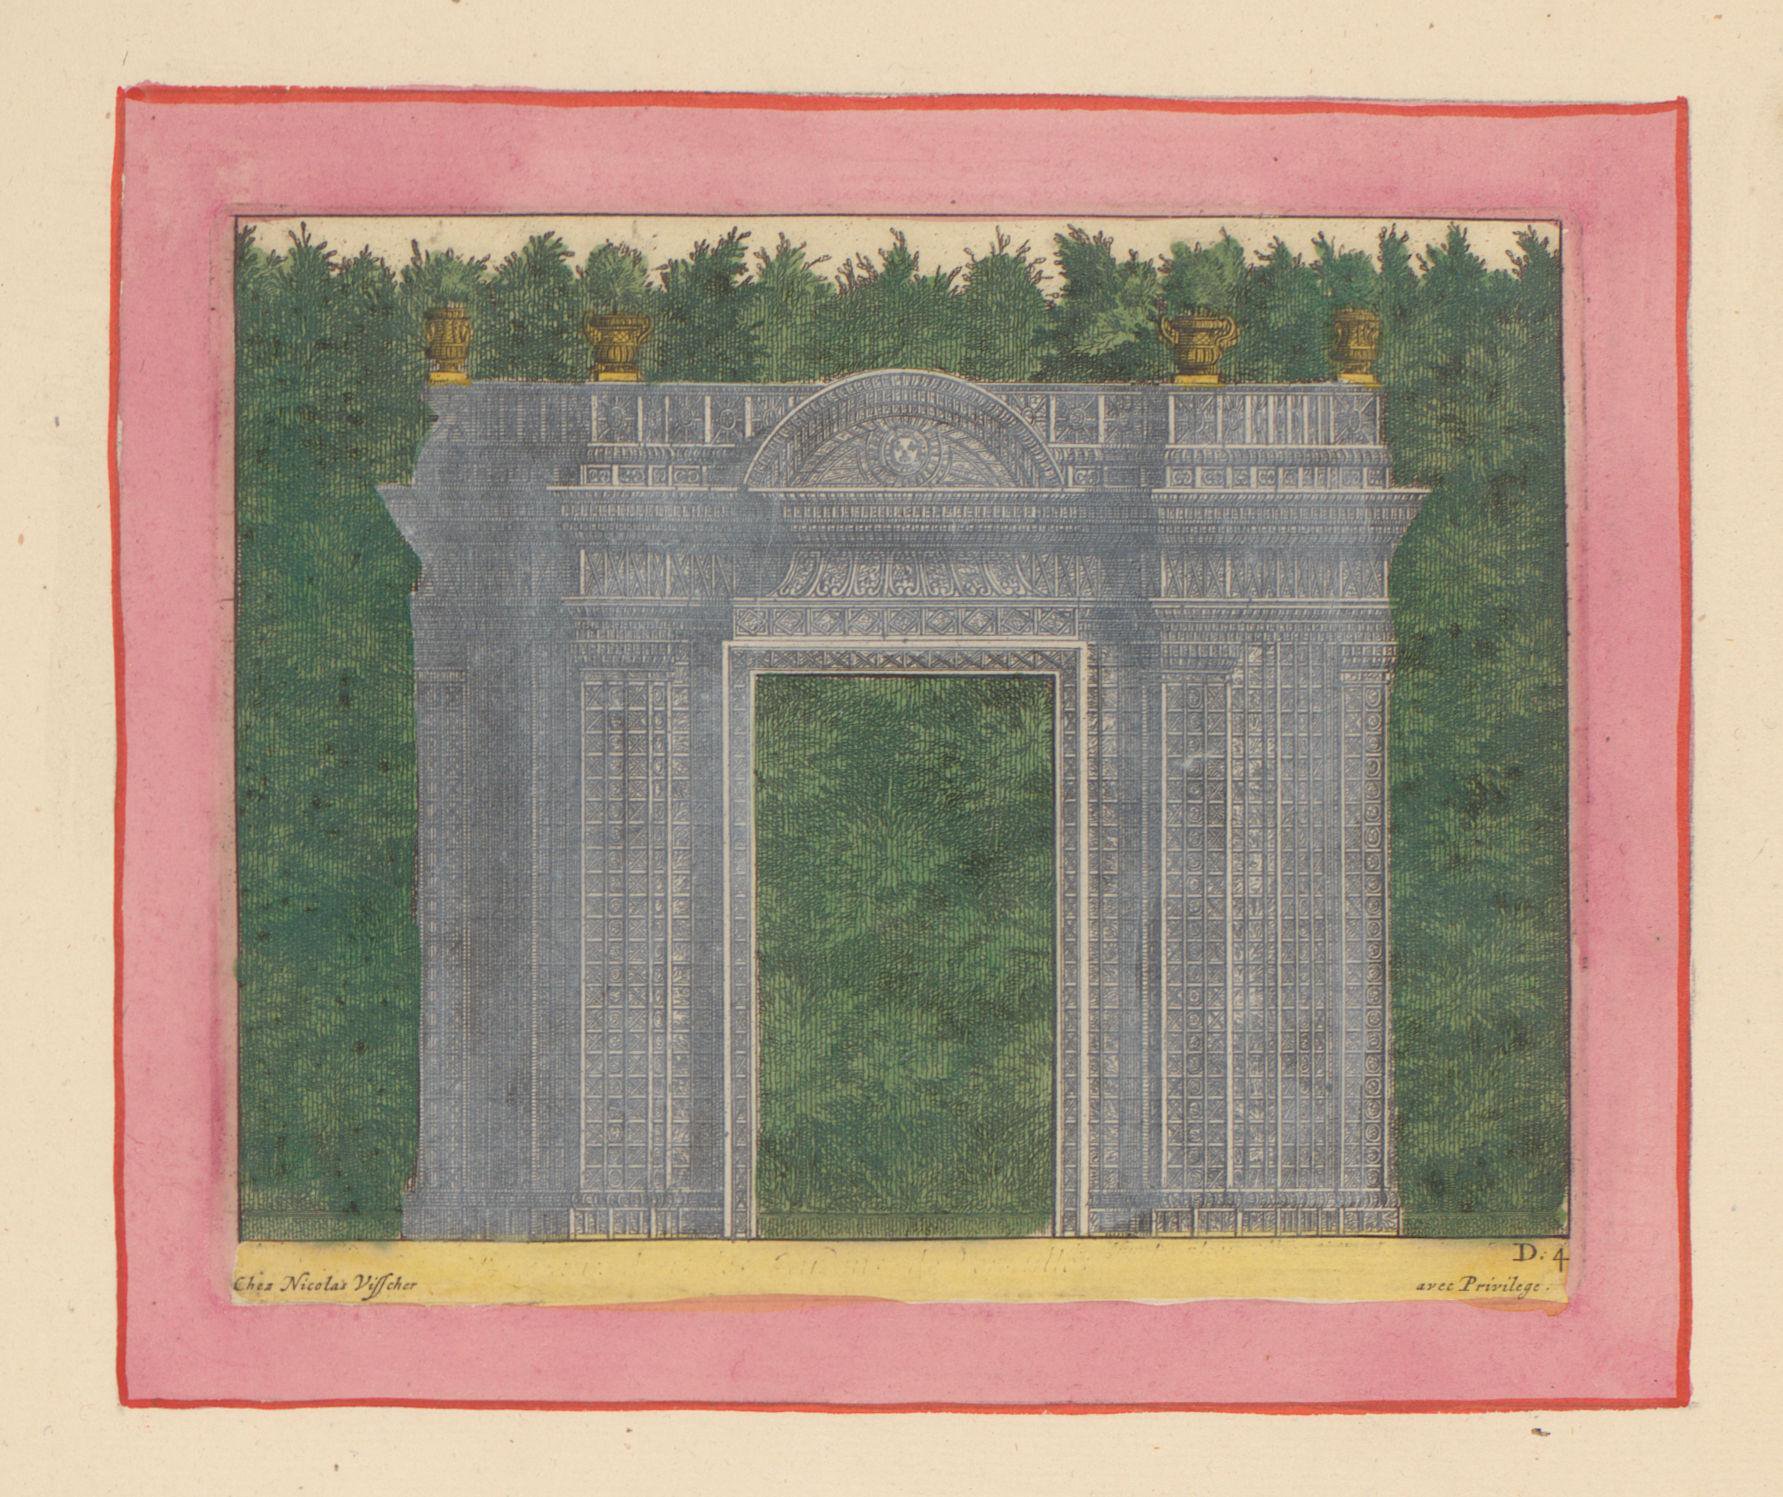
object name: album leaf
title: Veues de Versailles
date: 1686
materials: paper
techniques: etching, hand coloring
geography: amsterdam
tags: trellis, french or architectonic garden; formal garden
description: Poort van latwerk met bovenop vier tuinvazen voor een heg in de tuinen van Versailles. Rechtsonder het serienummer: D4. Prent maakt deel uit van een album.